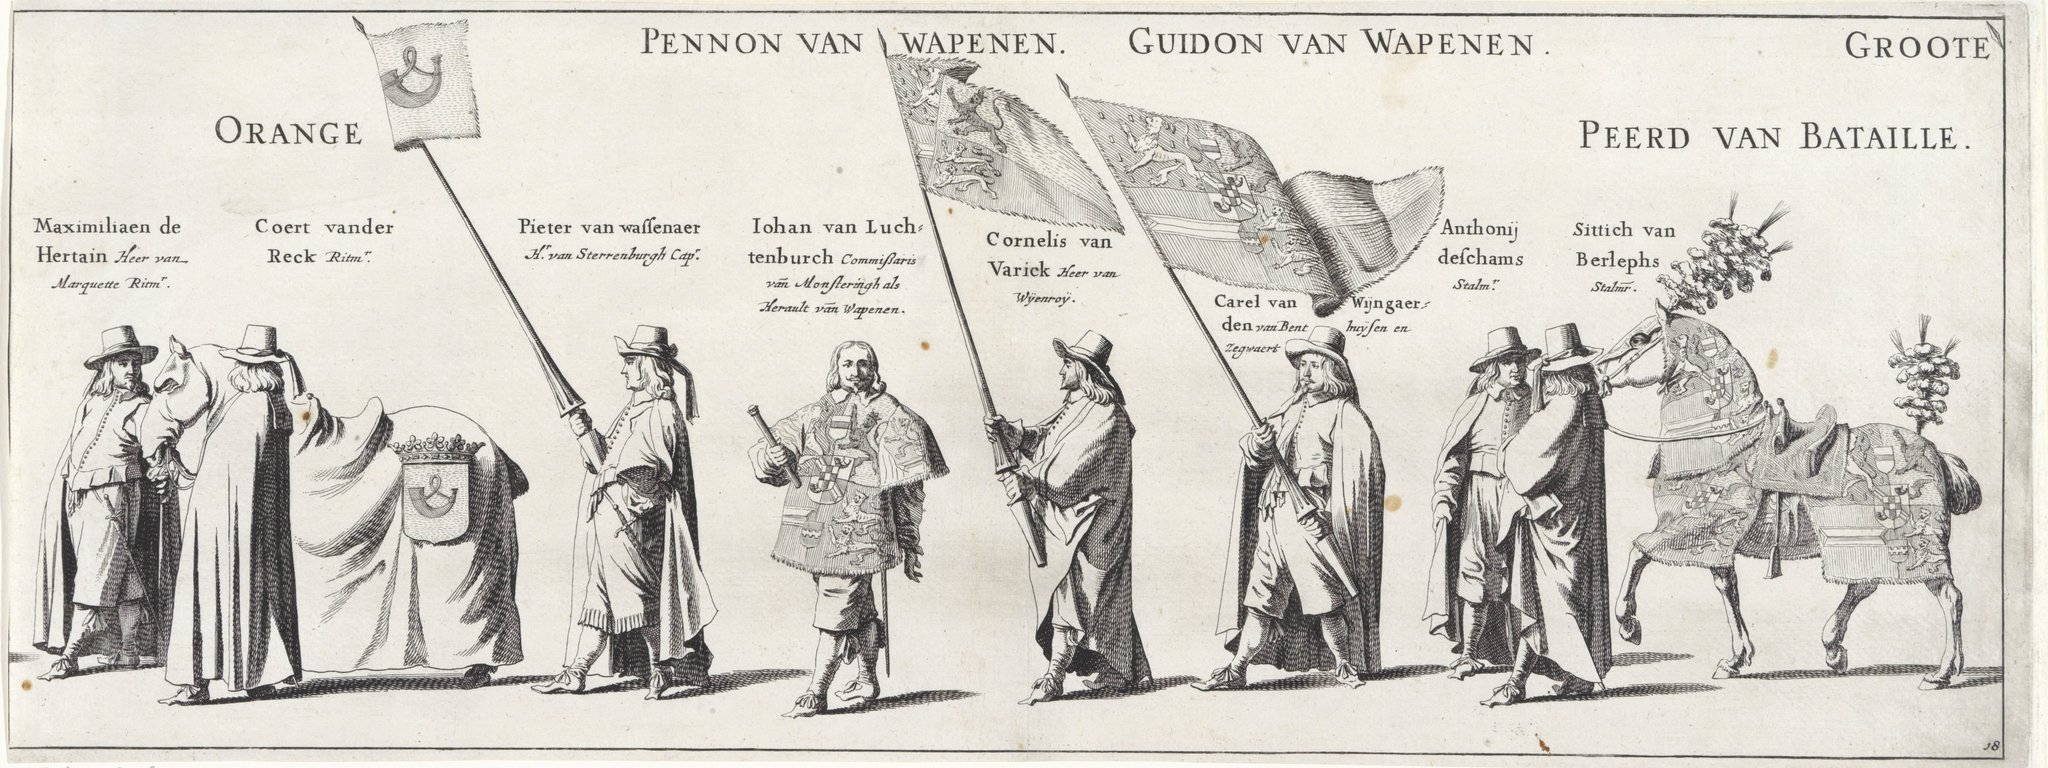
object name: print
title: De begrafenisstoet van stadhouder Frederik Hendrik te 's-Gravenhage in 1647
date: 1651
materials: paper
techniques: engraving, etching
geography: amsterdam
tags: cortege, funeral procession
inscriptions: collector's mark: Lugt 2228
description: De begrafenisstoet van stadhouder Frederik Hendrik te 's-Gravenhage op 10 mei 1647. Plaat nr. 18 met een deel van de stoet met vaandeldragers en twee paarden, boven de personen staan hun naam en functie. Onderdeel van een serie van 30 platen en 20 tekstbladen, bedoeld om aan elkaar geplakt te worden.